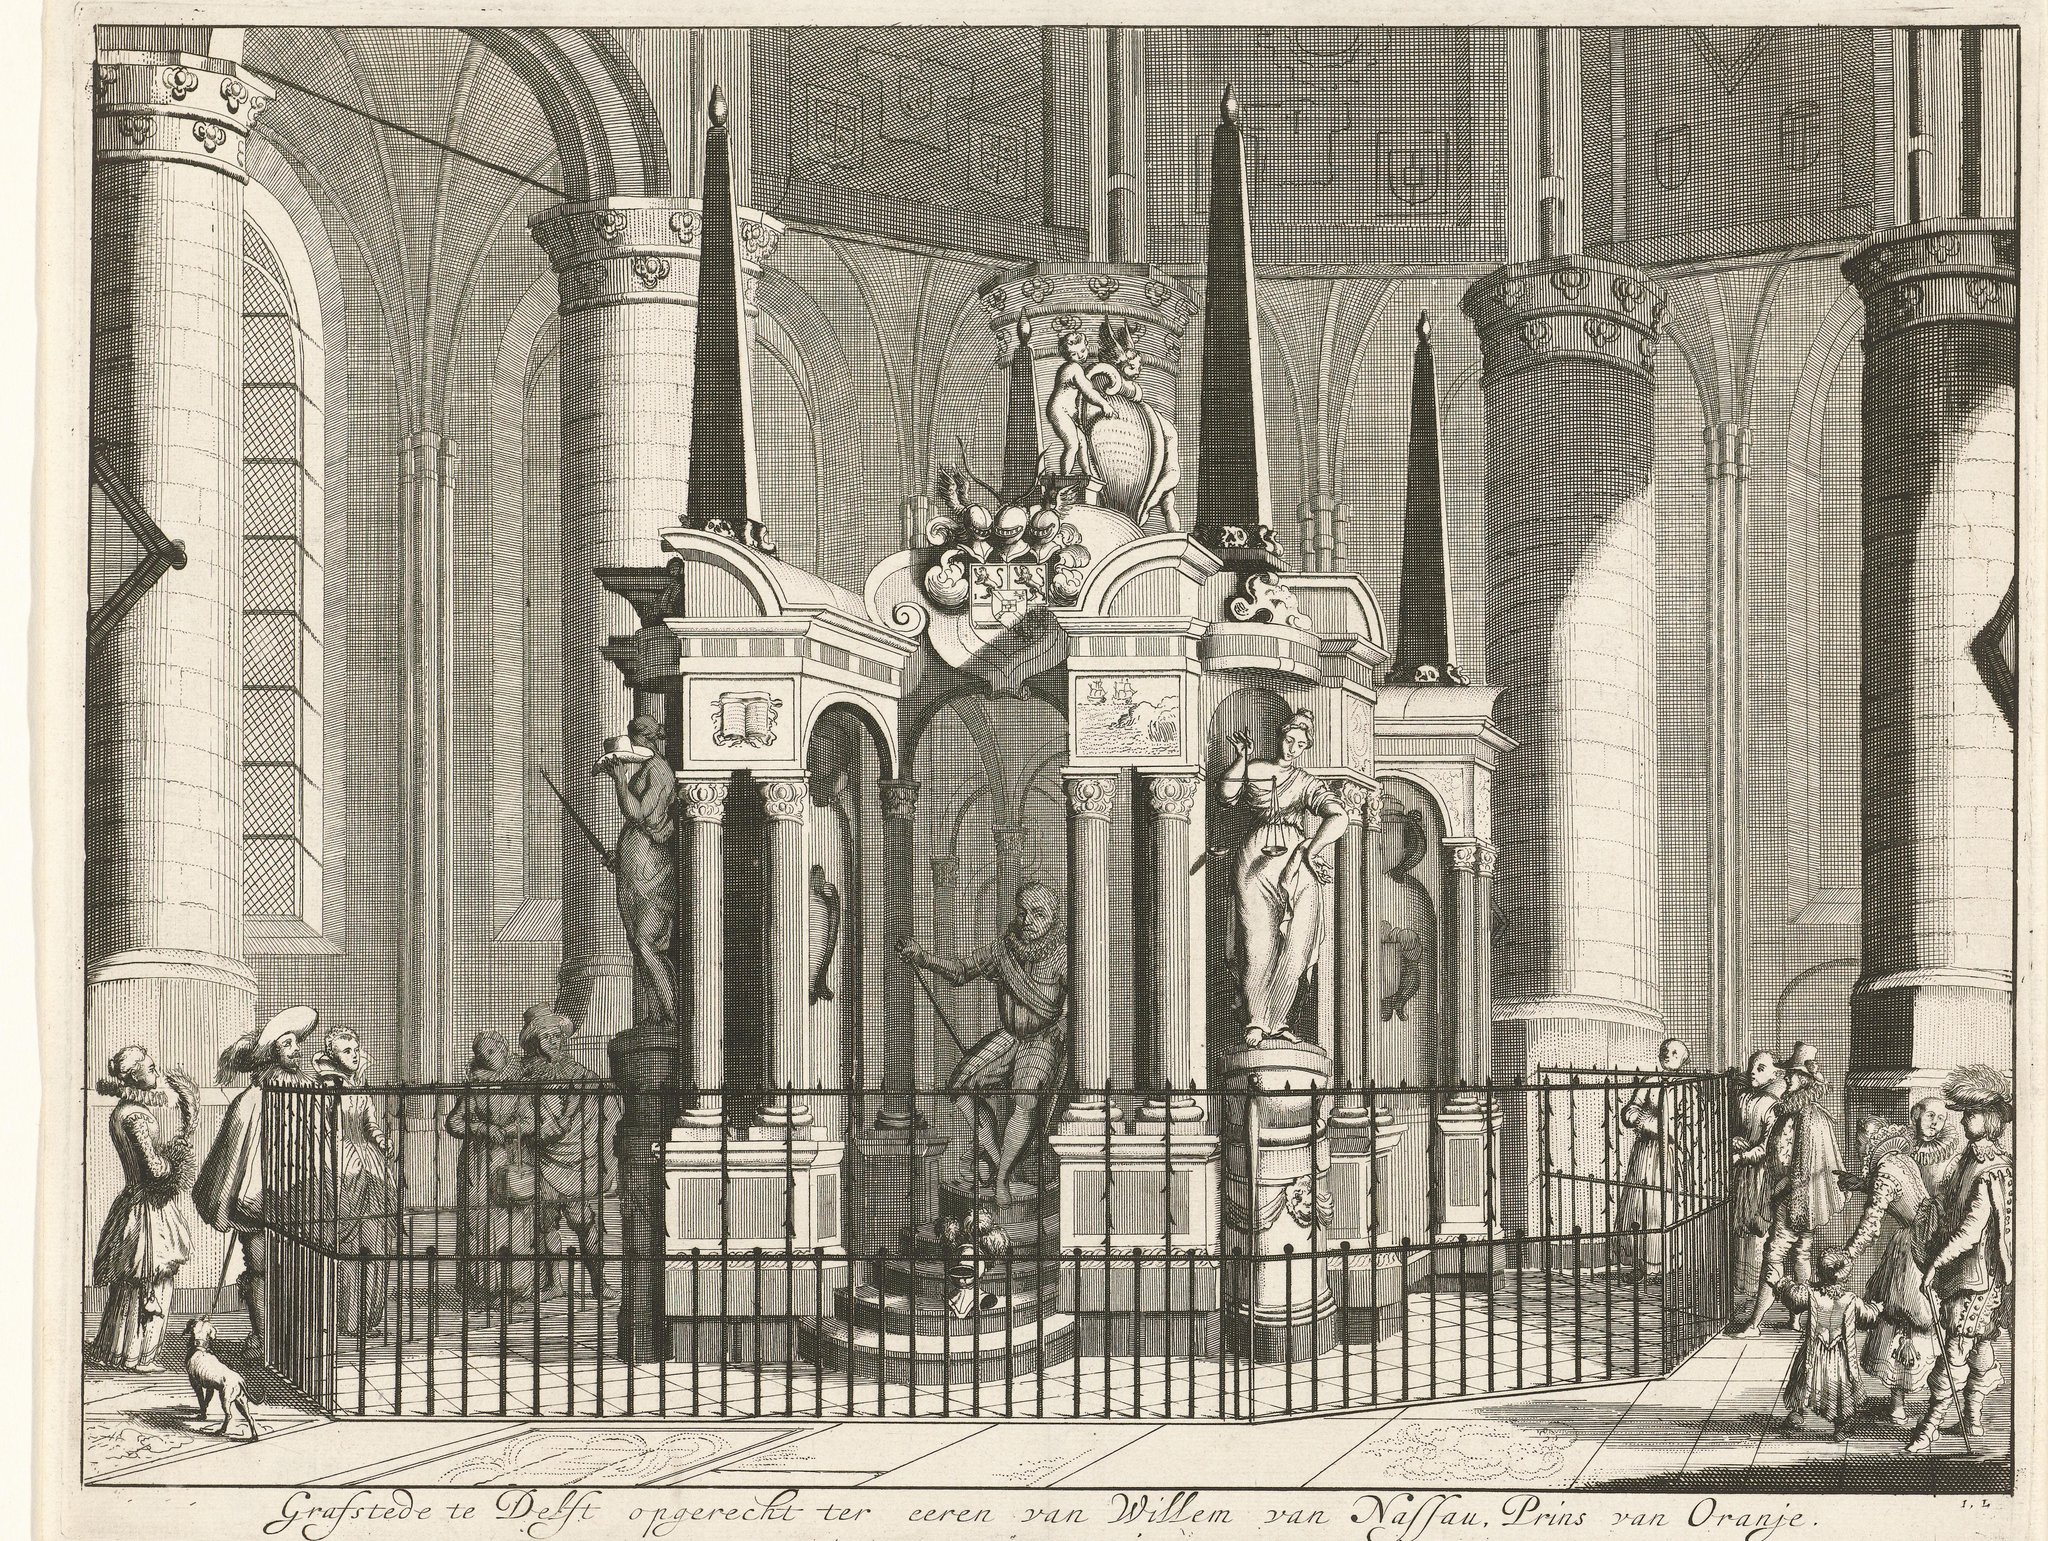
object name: historical object representation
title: De graftombe van Willem van Oranje, 1623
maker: jan luyken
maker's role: draughtsman, print maker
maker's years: 1649-1712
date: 1678-1680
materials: paper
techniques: etching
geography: northern netherlands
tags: delft, william i (prince of orange), grave-building, monumental tomb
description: Gebruikt als illustratie in: P. Bor Christiaensz., Oorsprongk, begin, en vervolgh der Nederlandsche Oorlogen, Amsterdam 1679-1684, 4 delen, dl. II, p. 436.